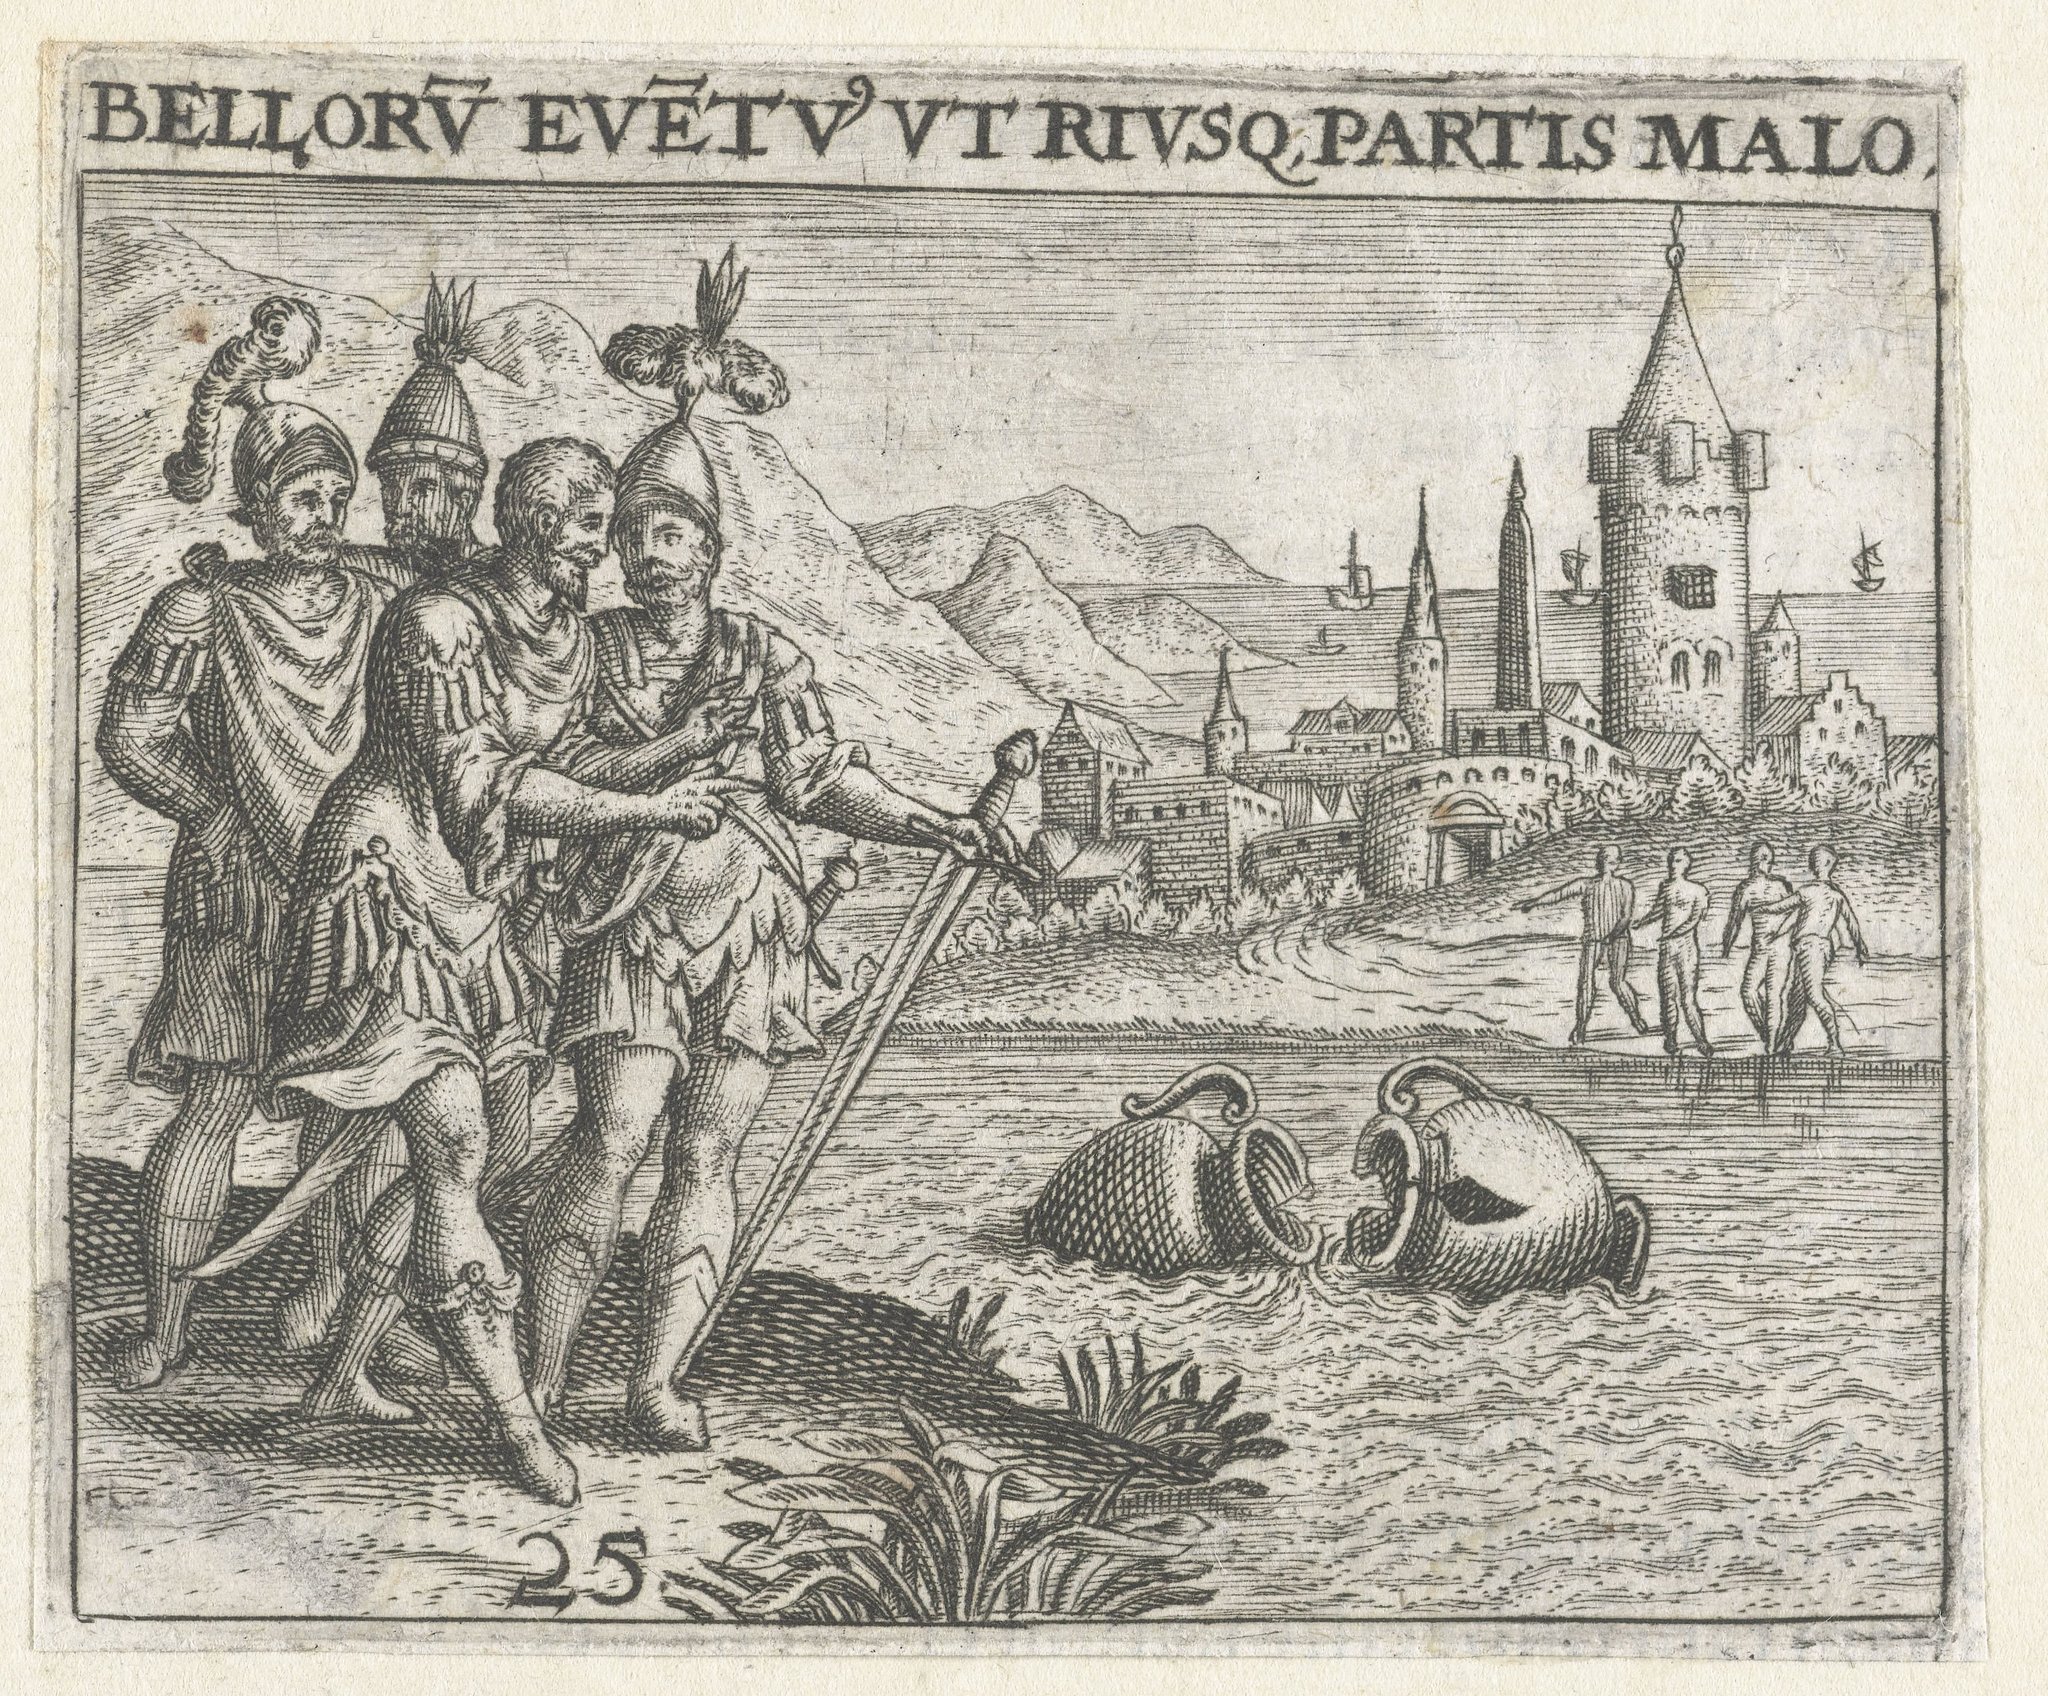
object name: print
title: Soldaten kijken naar twee kruiken die in het water drijven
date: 1596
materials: paper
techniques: engraving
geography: frankfurt am main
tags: container of ceramics: jar, jug, pot, vase (+ ceramics and glass), soldiers and civilians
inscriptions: collector's mark: Lugt 240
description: Vier soldaten staan langs de oever van een rivier. In het water drijven twee kapotte kruiken. Aan de overkant van de rivier staan vier mannen die eveneens naar de kruiken te kijken.